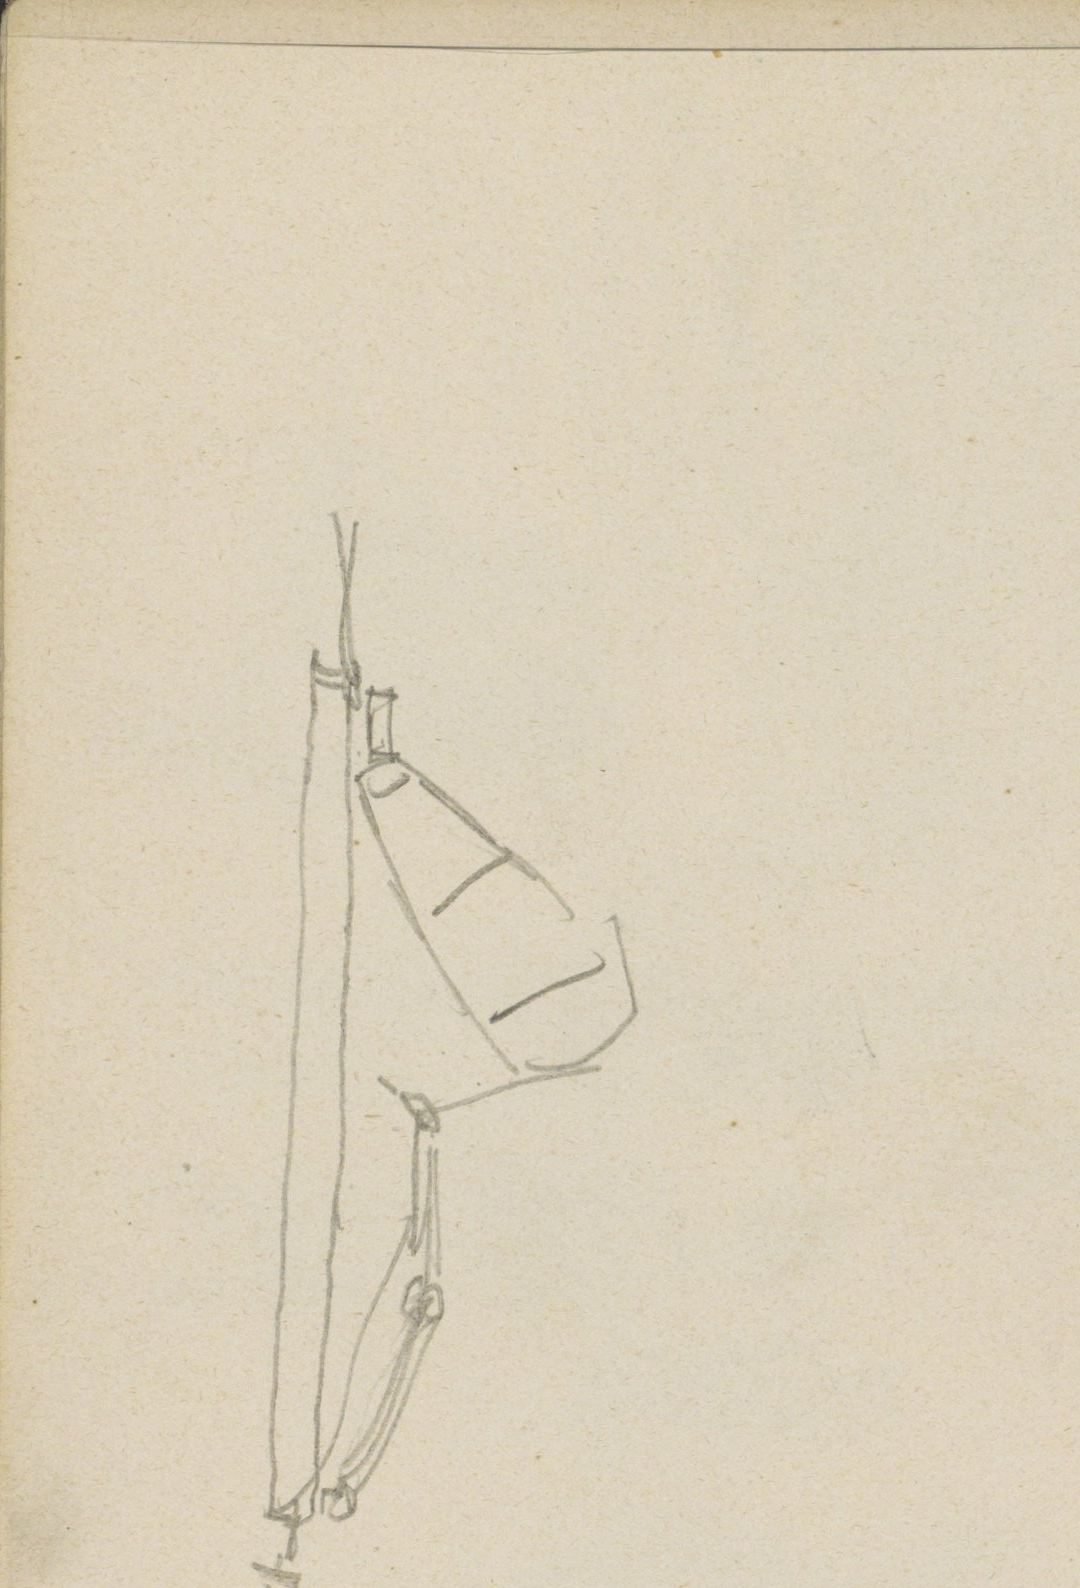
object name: sketchbook leaf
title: Studie van een voorwerp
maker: george hendrik breitner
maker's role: draughtsman, painter, print maker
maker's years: 1857-1923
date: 1909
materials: paper, pencil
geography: amsterdam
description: Studie van een voorwerp. Pagina 7 uit een schetsboek met 45 bladen vervaardigd in Amsterdam en Pittsburgh.